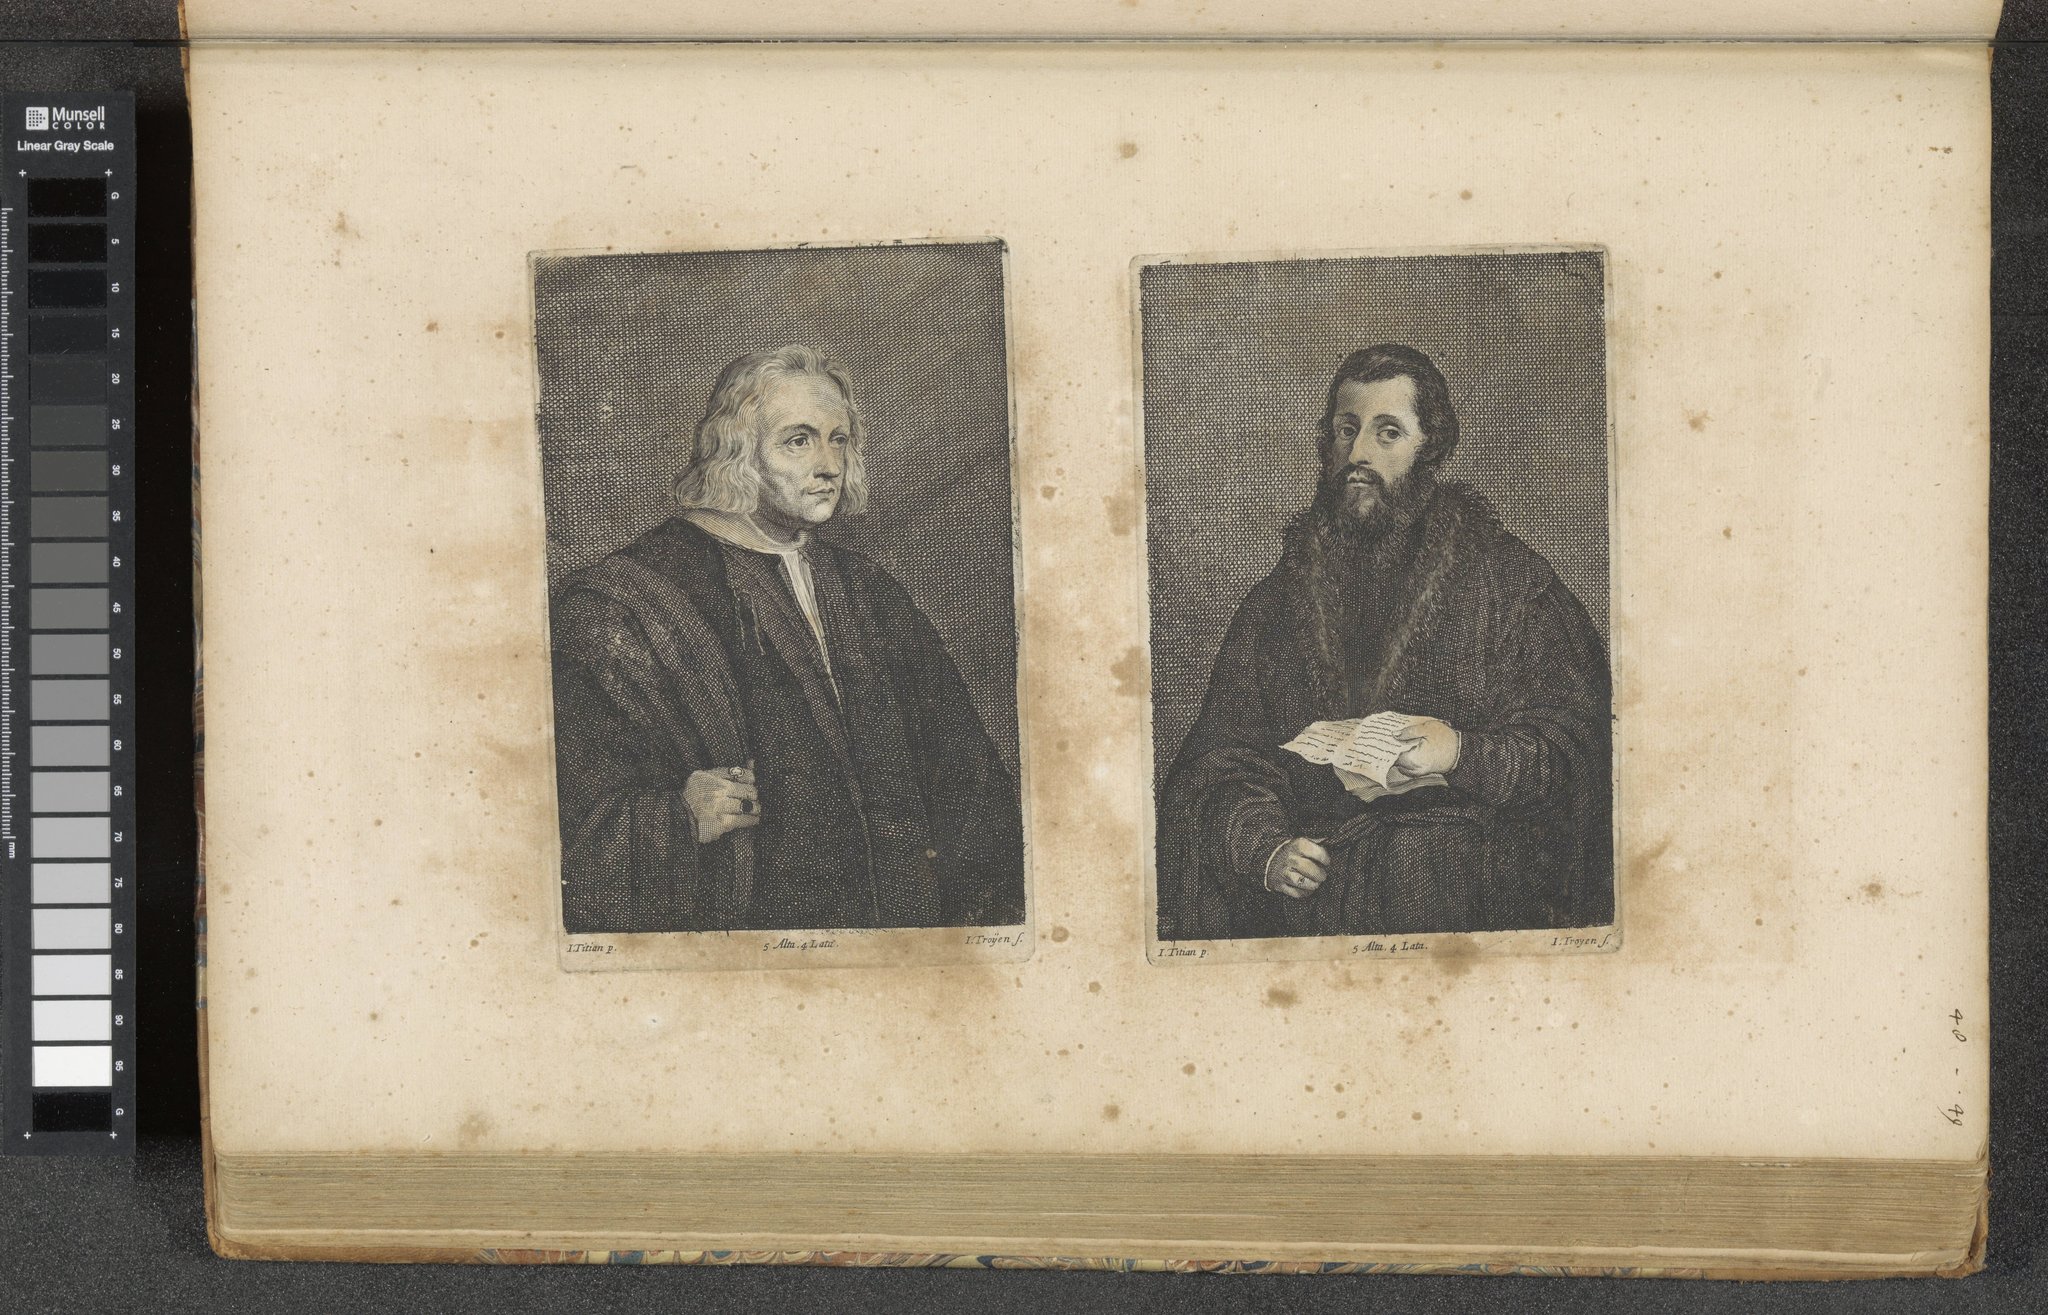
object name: album leaf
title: Portret van een onbekende man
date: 1660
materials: paper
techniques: etching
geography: southern netherlands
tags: anonymous historical person portrayed, letter, envelope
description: De prent is vervaardigd naar het schilderij van Silvio dat zich in de collectie van het Kunsthistorisches Museum te Wenen bevindt (inventarisnummer: GG_1537). David Teniers heeft waarschijnlijk van alle schilderijen uit de collectie van Leopold Willem van Oostenrijk een olieverfstudie op doek of paneel vervaardigd (zgn. pasticcio), die als voorbeeld voor de prentmakers diende. Het is niet altijd duidelijk of de pasticci door hem zijn gemaakt of door zijn atelier. Niet alle pasticci zijn overgeleverd.